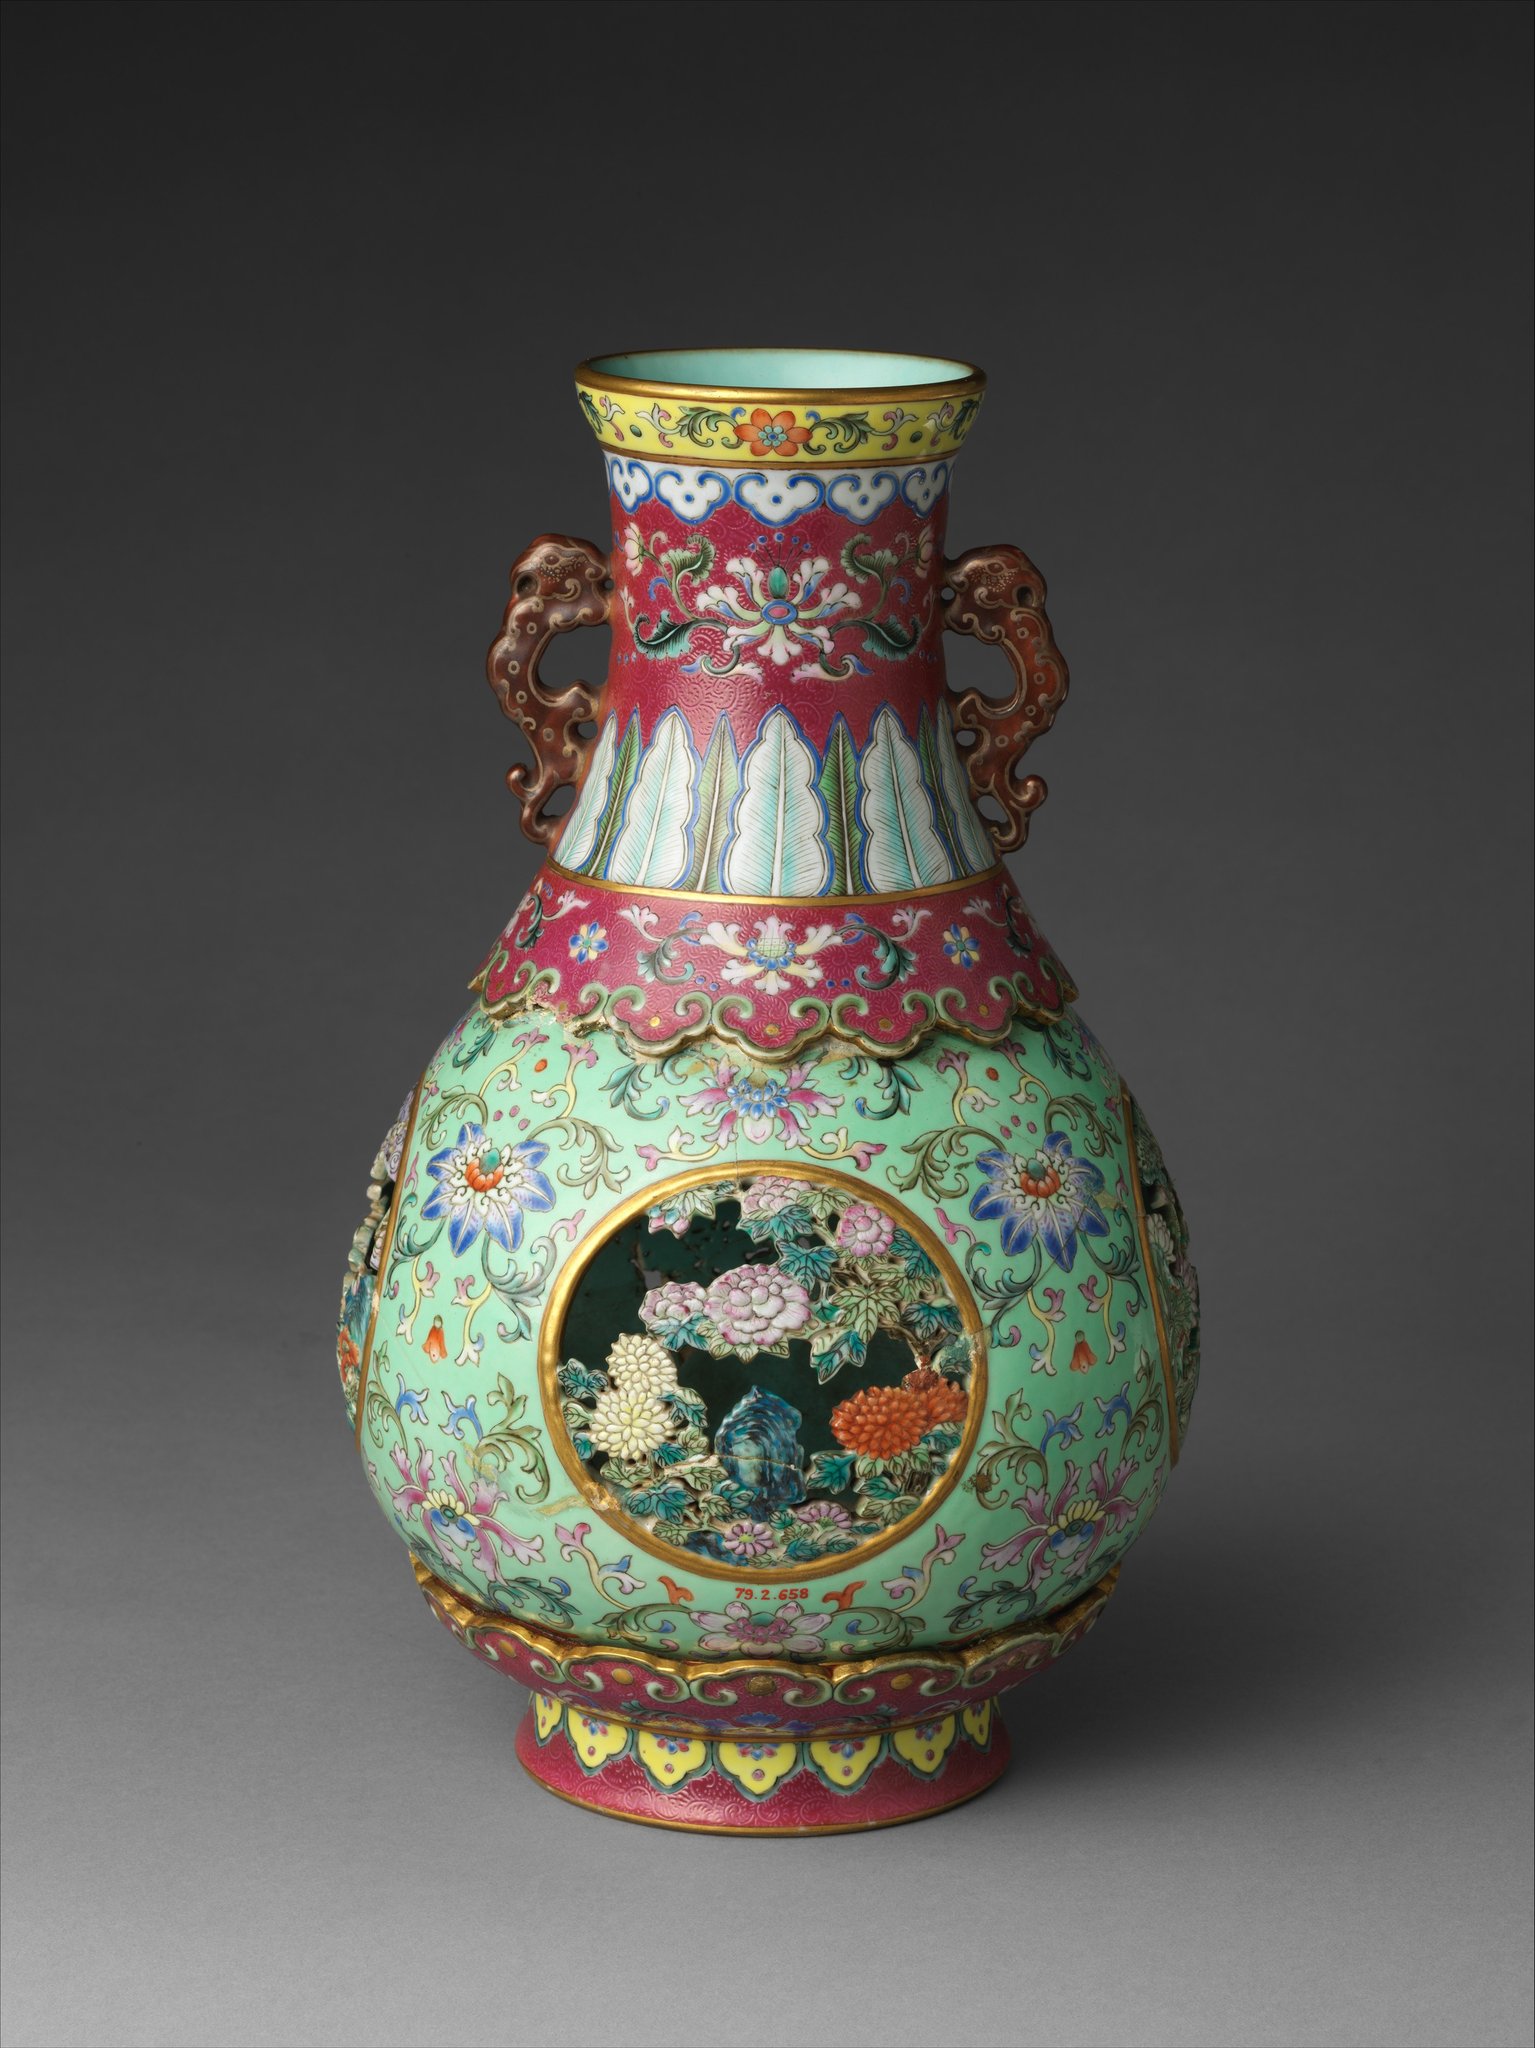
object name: vase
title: Vase with openwork ornaments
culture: chinese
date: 1734-1766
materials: enamel, gilt, porcelain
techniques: engraving, overglaze, painting, polychrome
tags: flowers